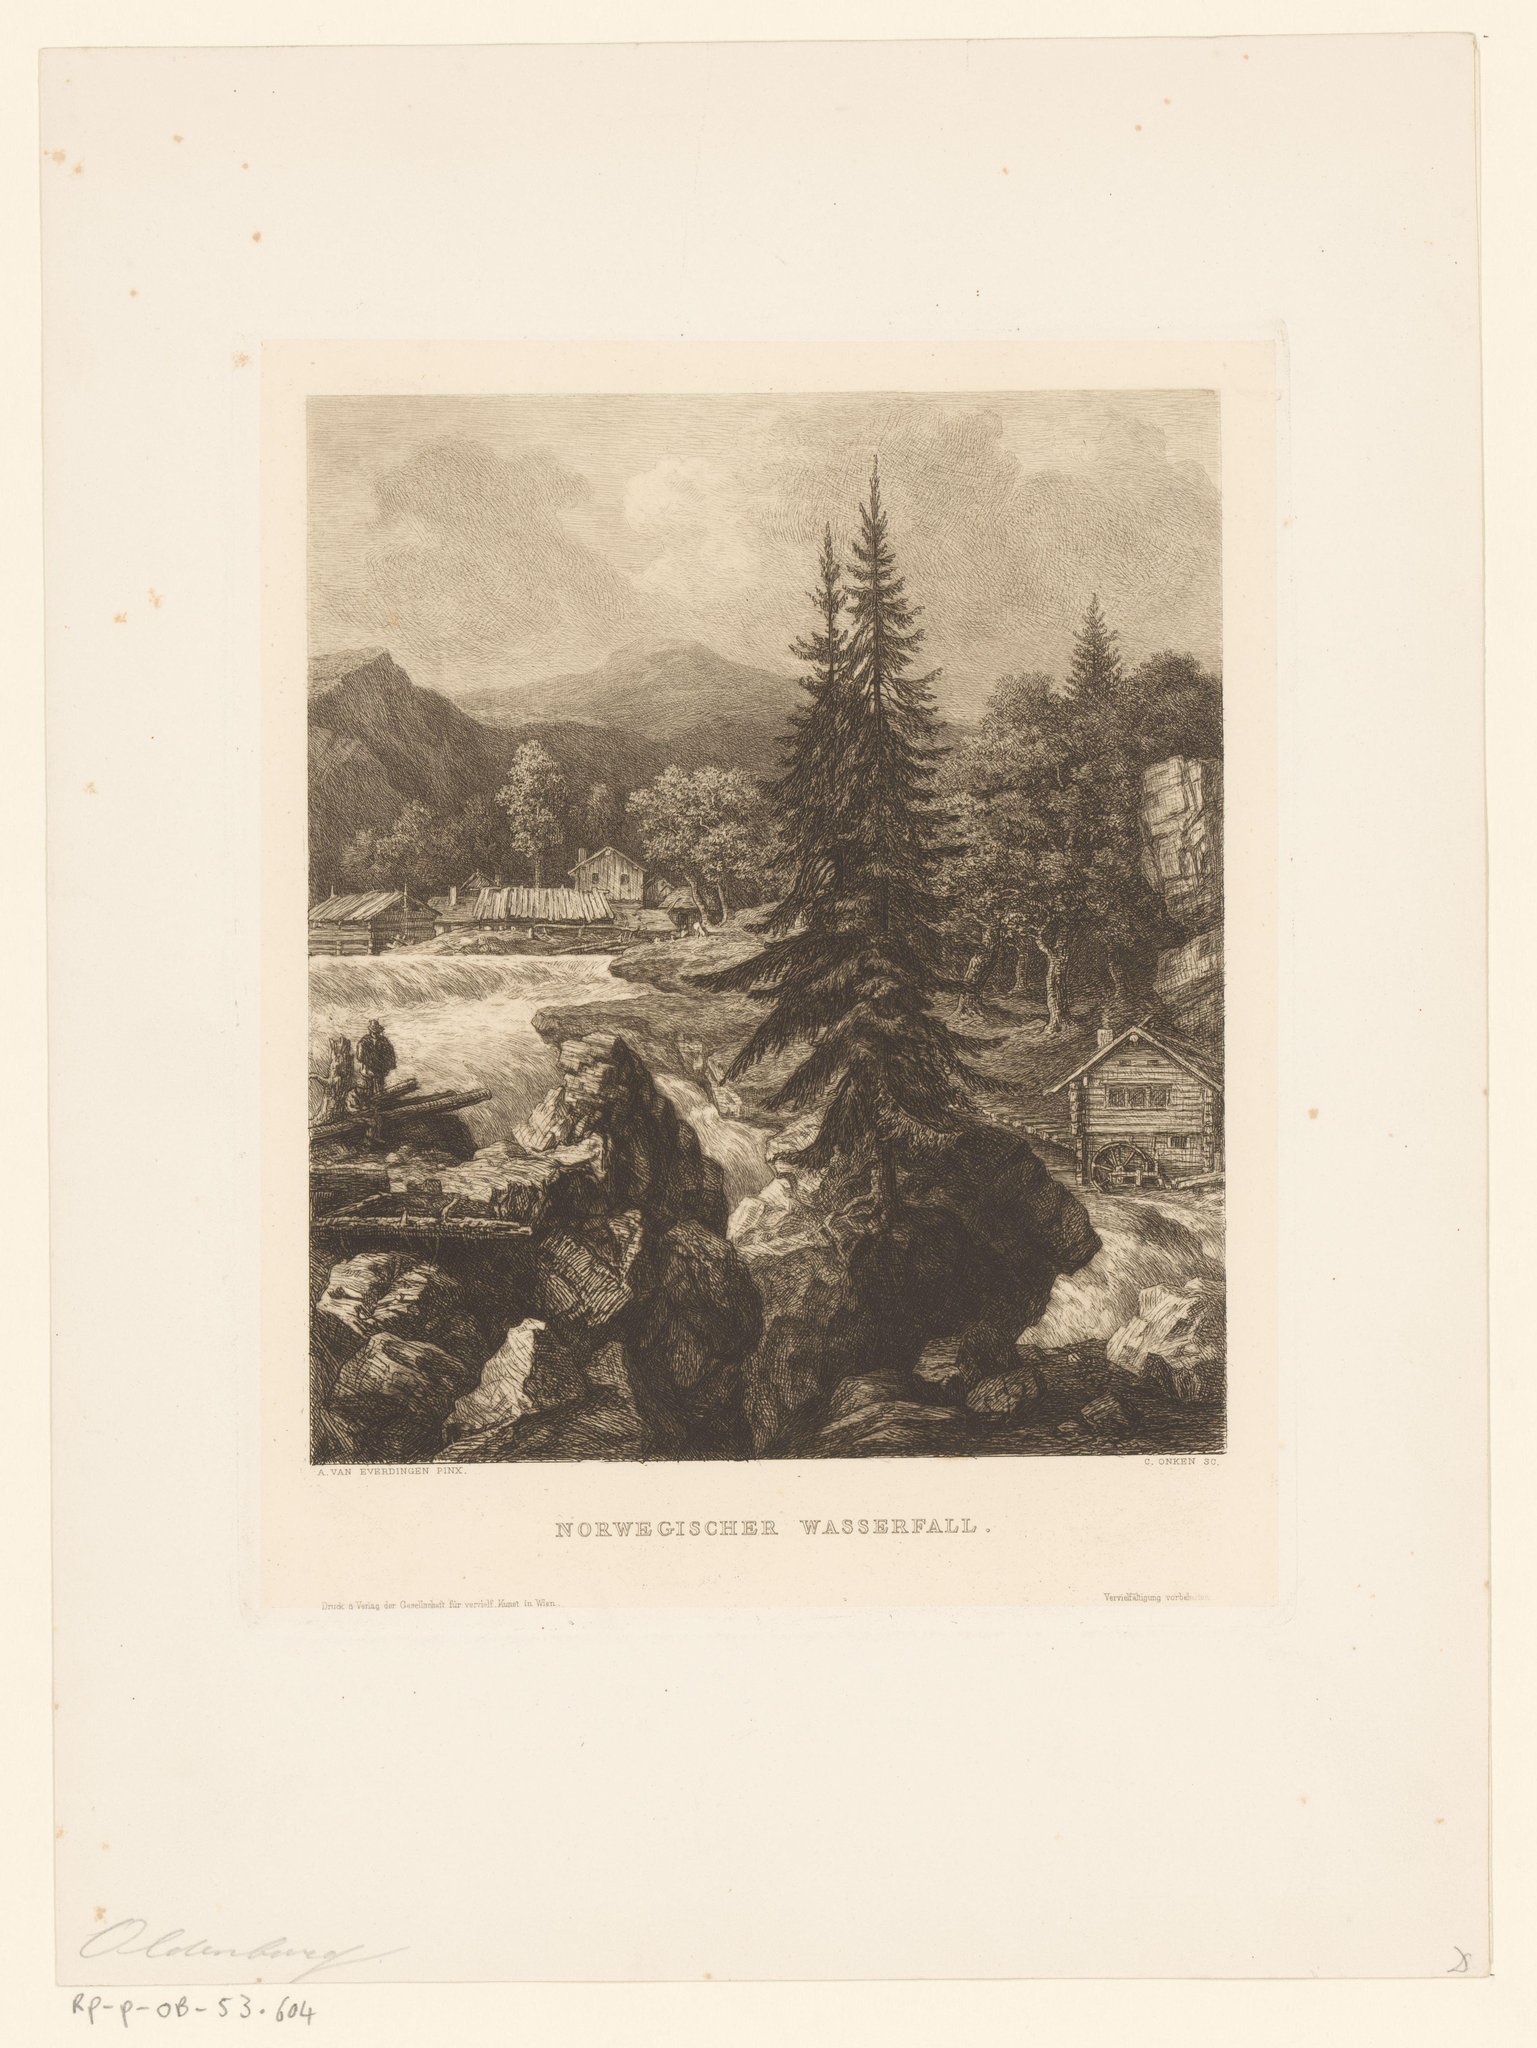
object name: print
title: Waterval in Noorwegen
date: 1861-1934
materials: paper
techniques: etching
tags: waterfall, watermill, norway